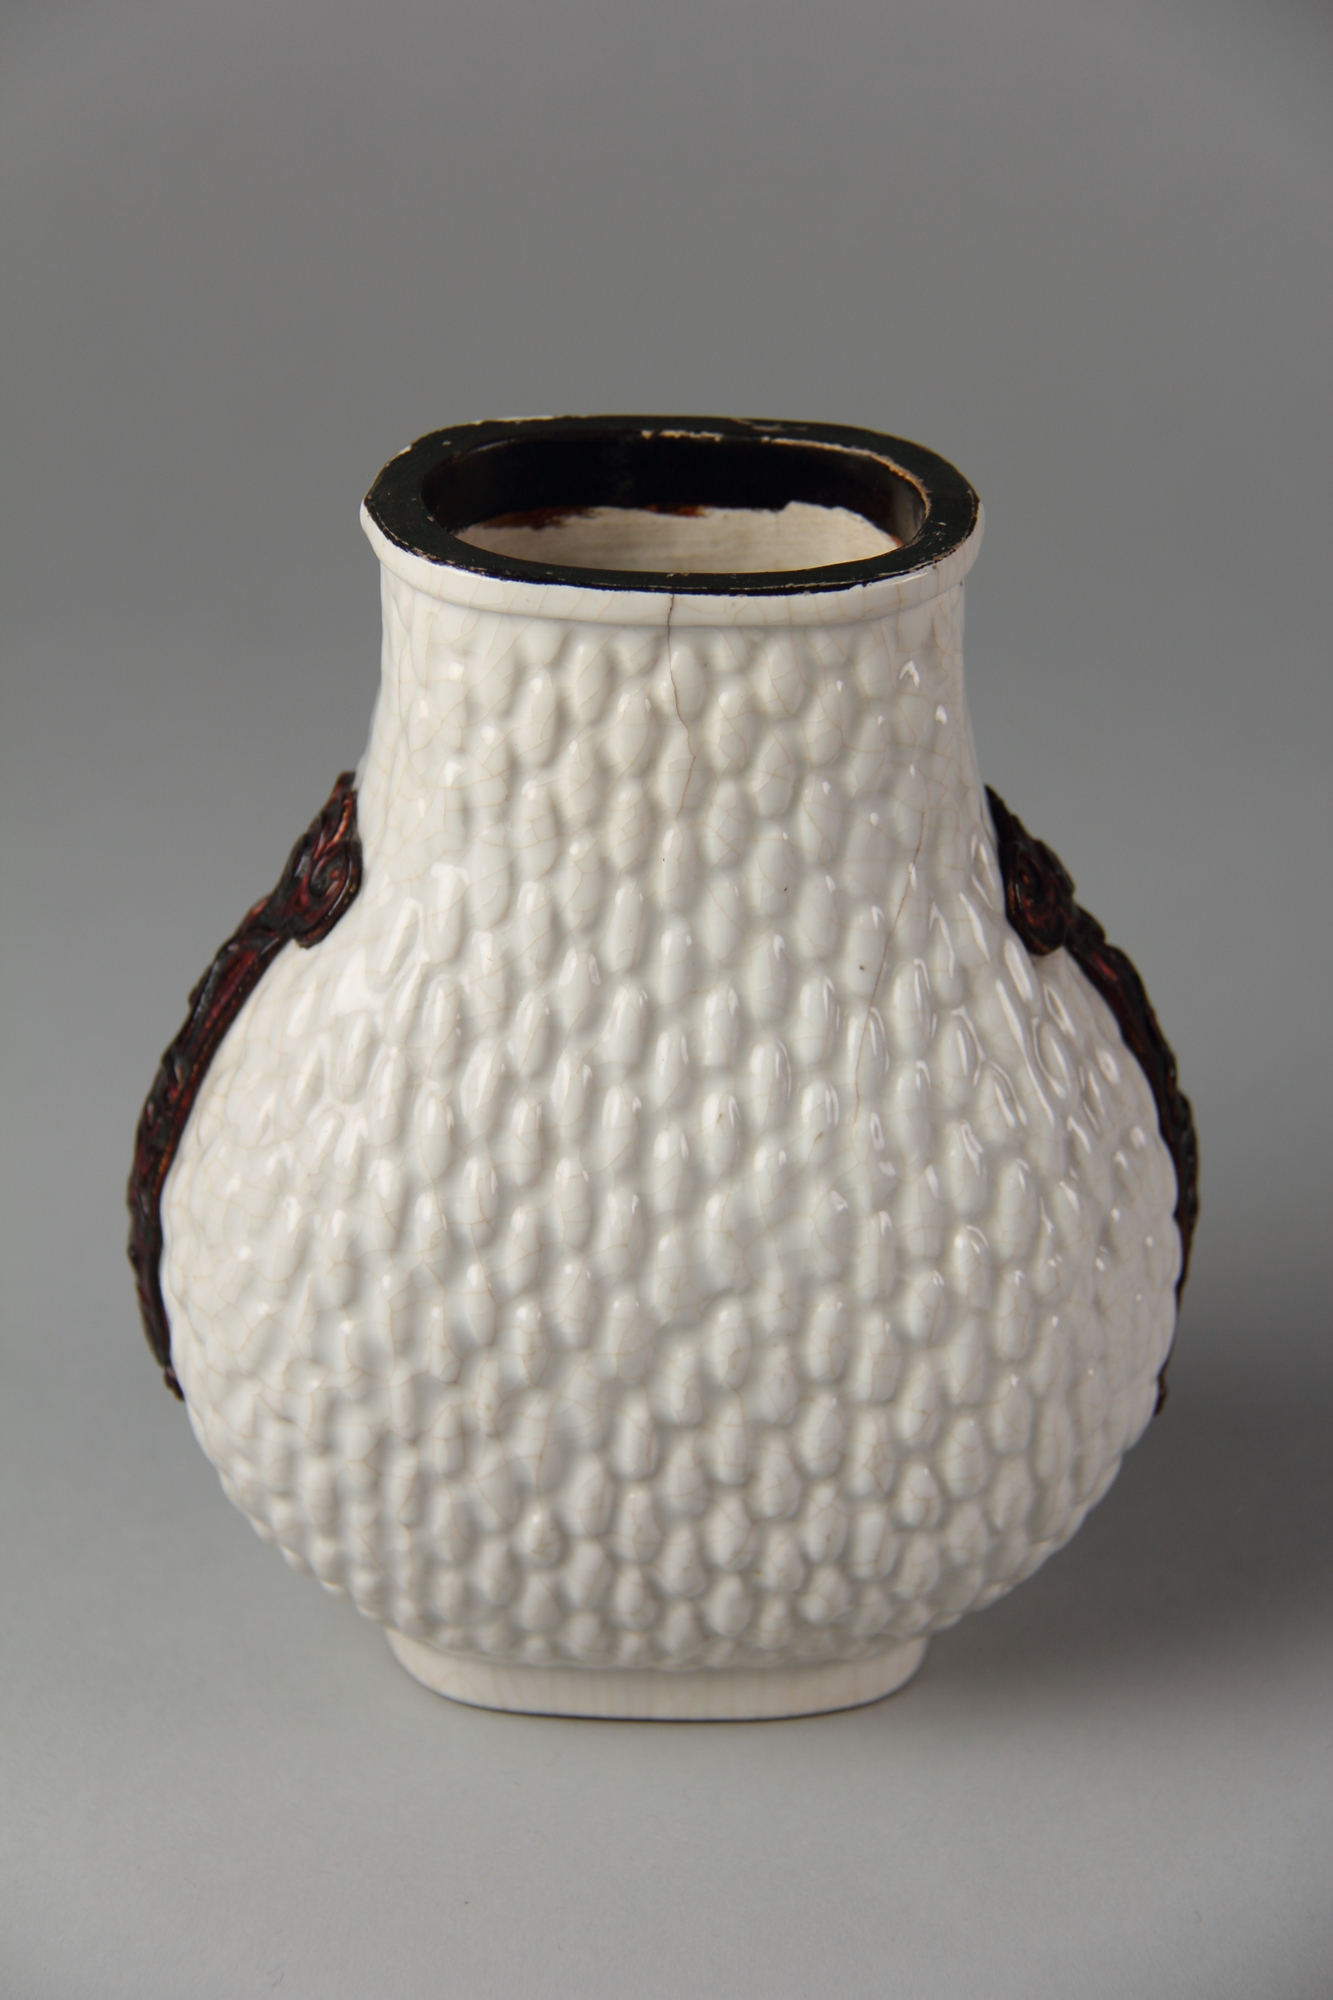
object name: vase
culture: chinese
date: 1801-1850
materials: glaze, porcelain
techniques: molding